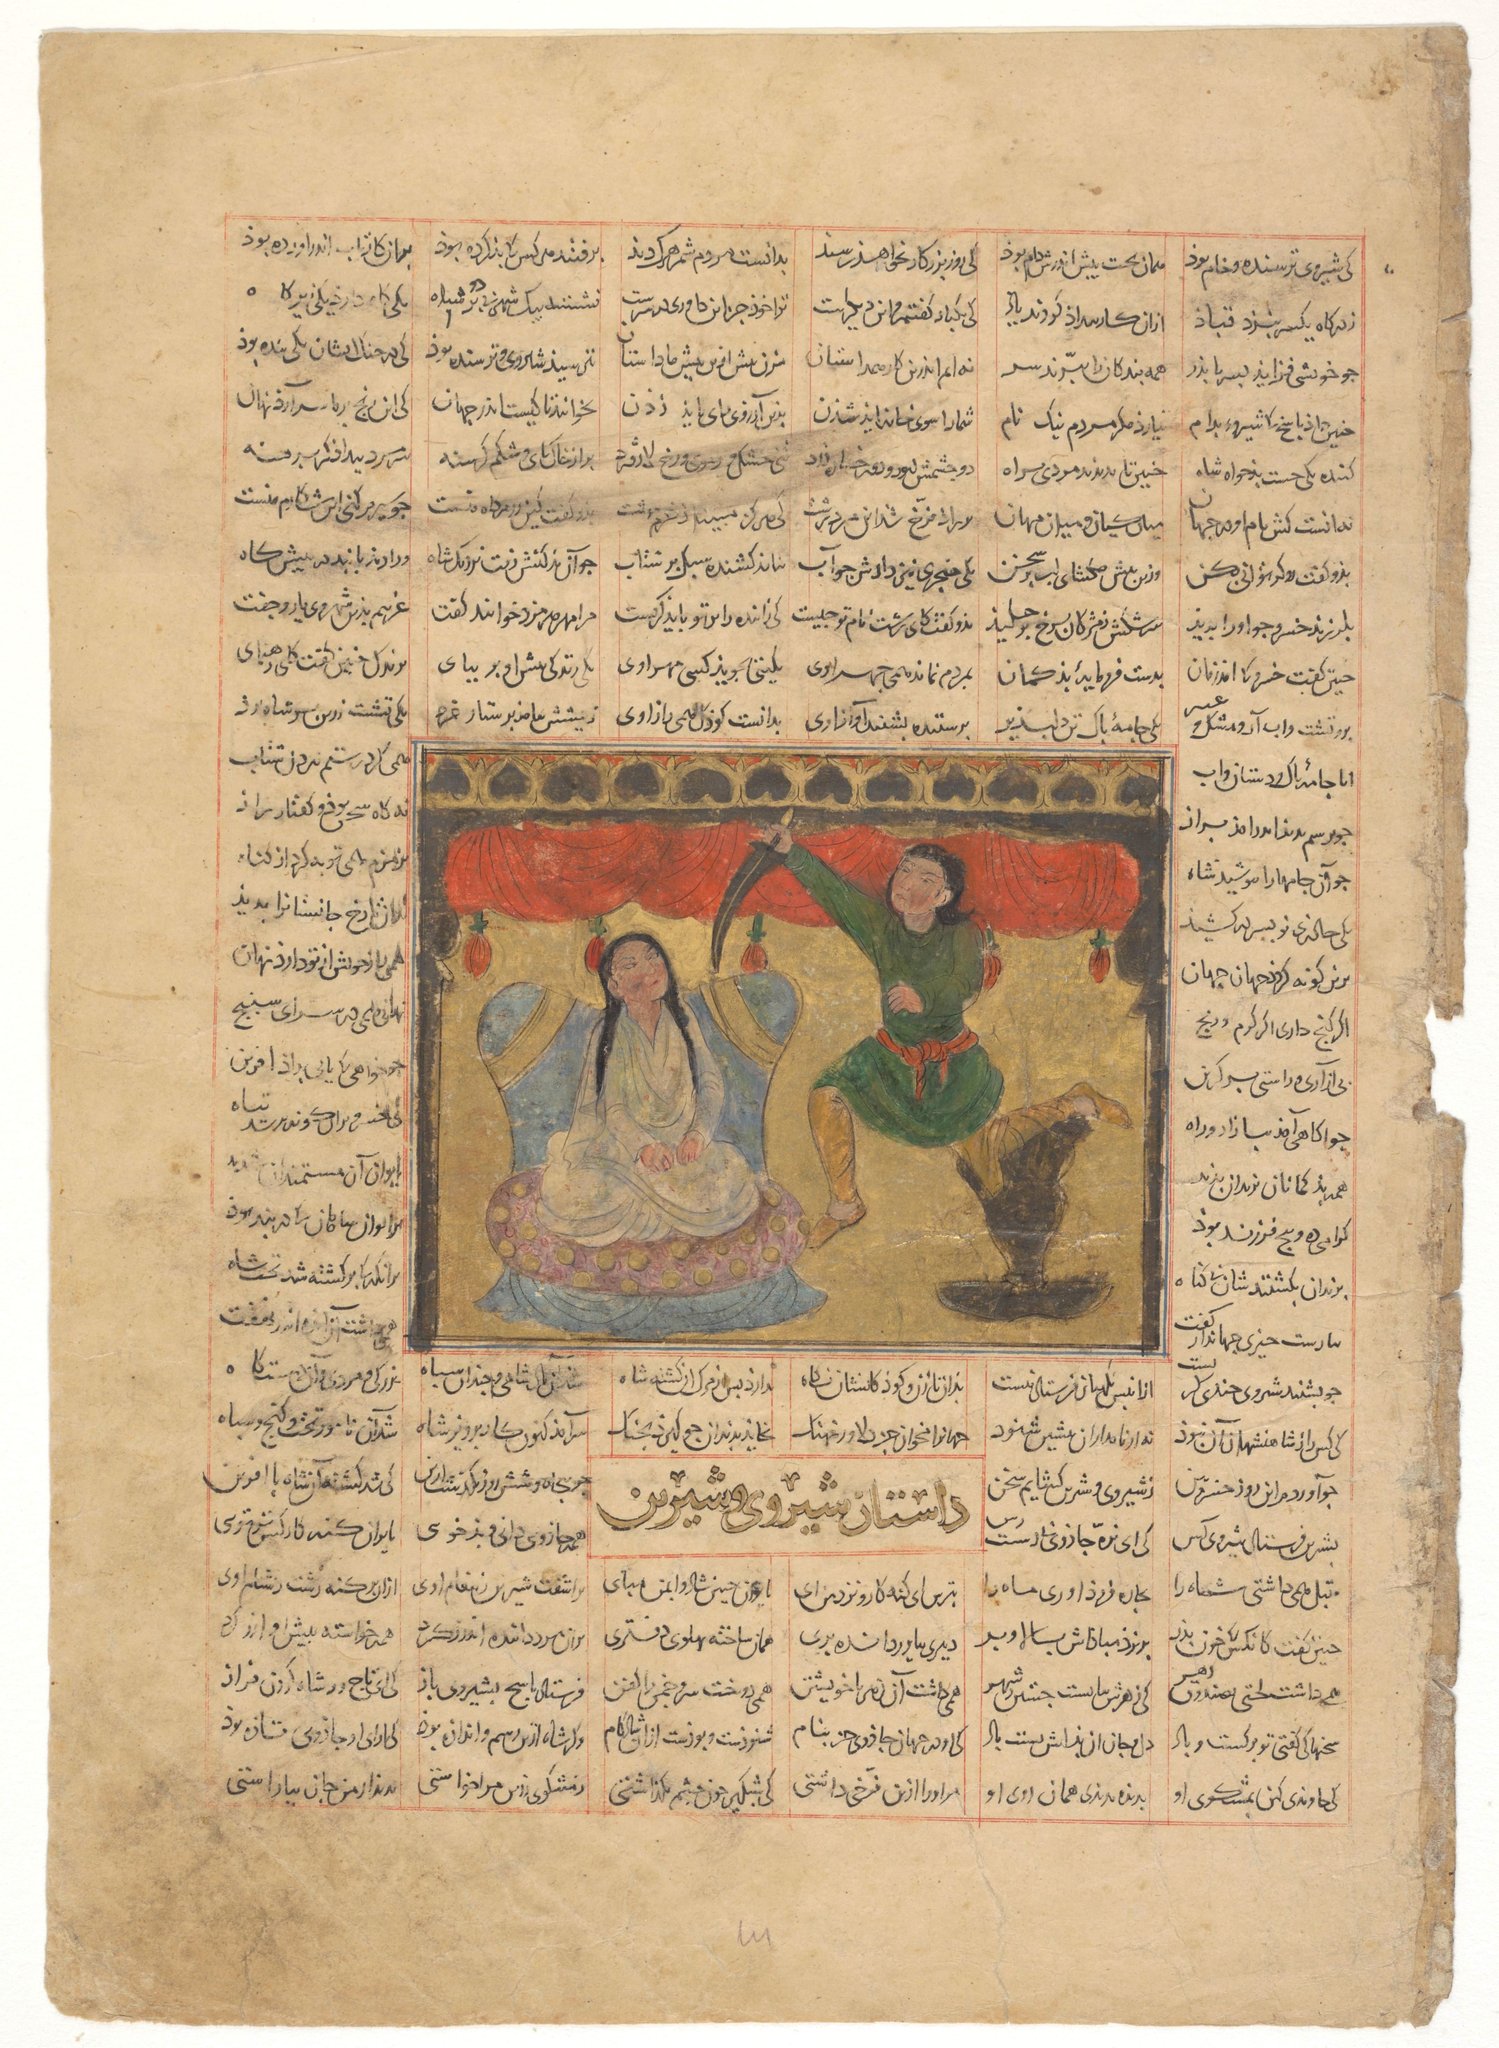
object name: persian miniature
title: Dood van Khusran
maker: Anonymous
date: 1400-1500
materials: paper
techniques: brush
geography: iran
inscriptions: inscription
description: Tegen een goudkleurige achtergrond onder een rood rolgordijn zit een vrouw op een lichtblauwe zetel, rechts van haar een man in groen met een zwaard; de voorstelling is in het midden van het blad geplaatst en rondom zijn kolommen tekst in oud-Perzisch. Het blad is aan de rechterkant verkleurd en ingescheurd (of ergens uitgescheurd).